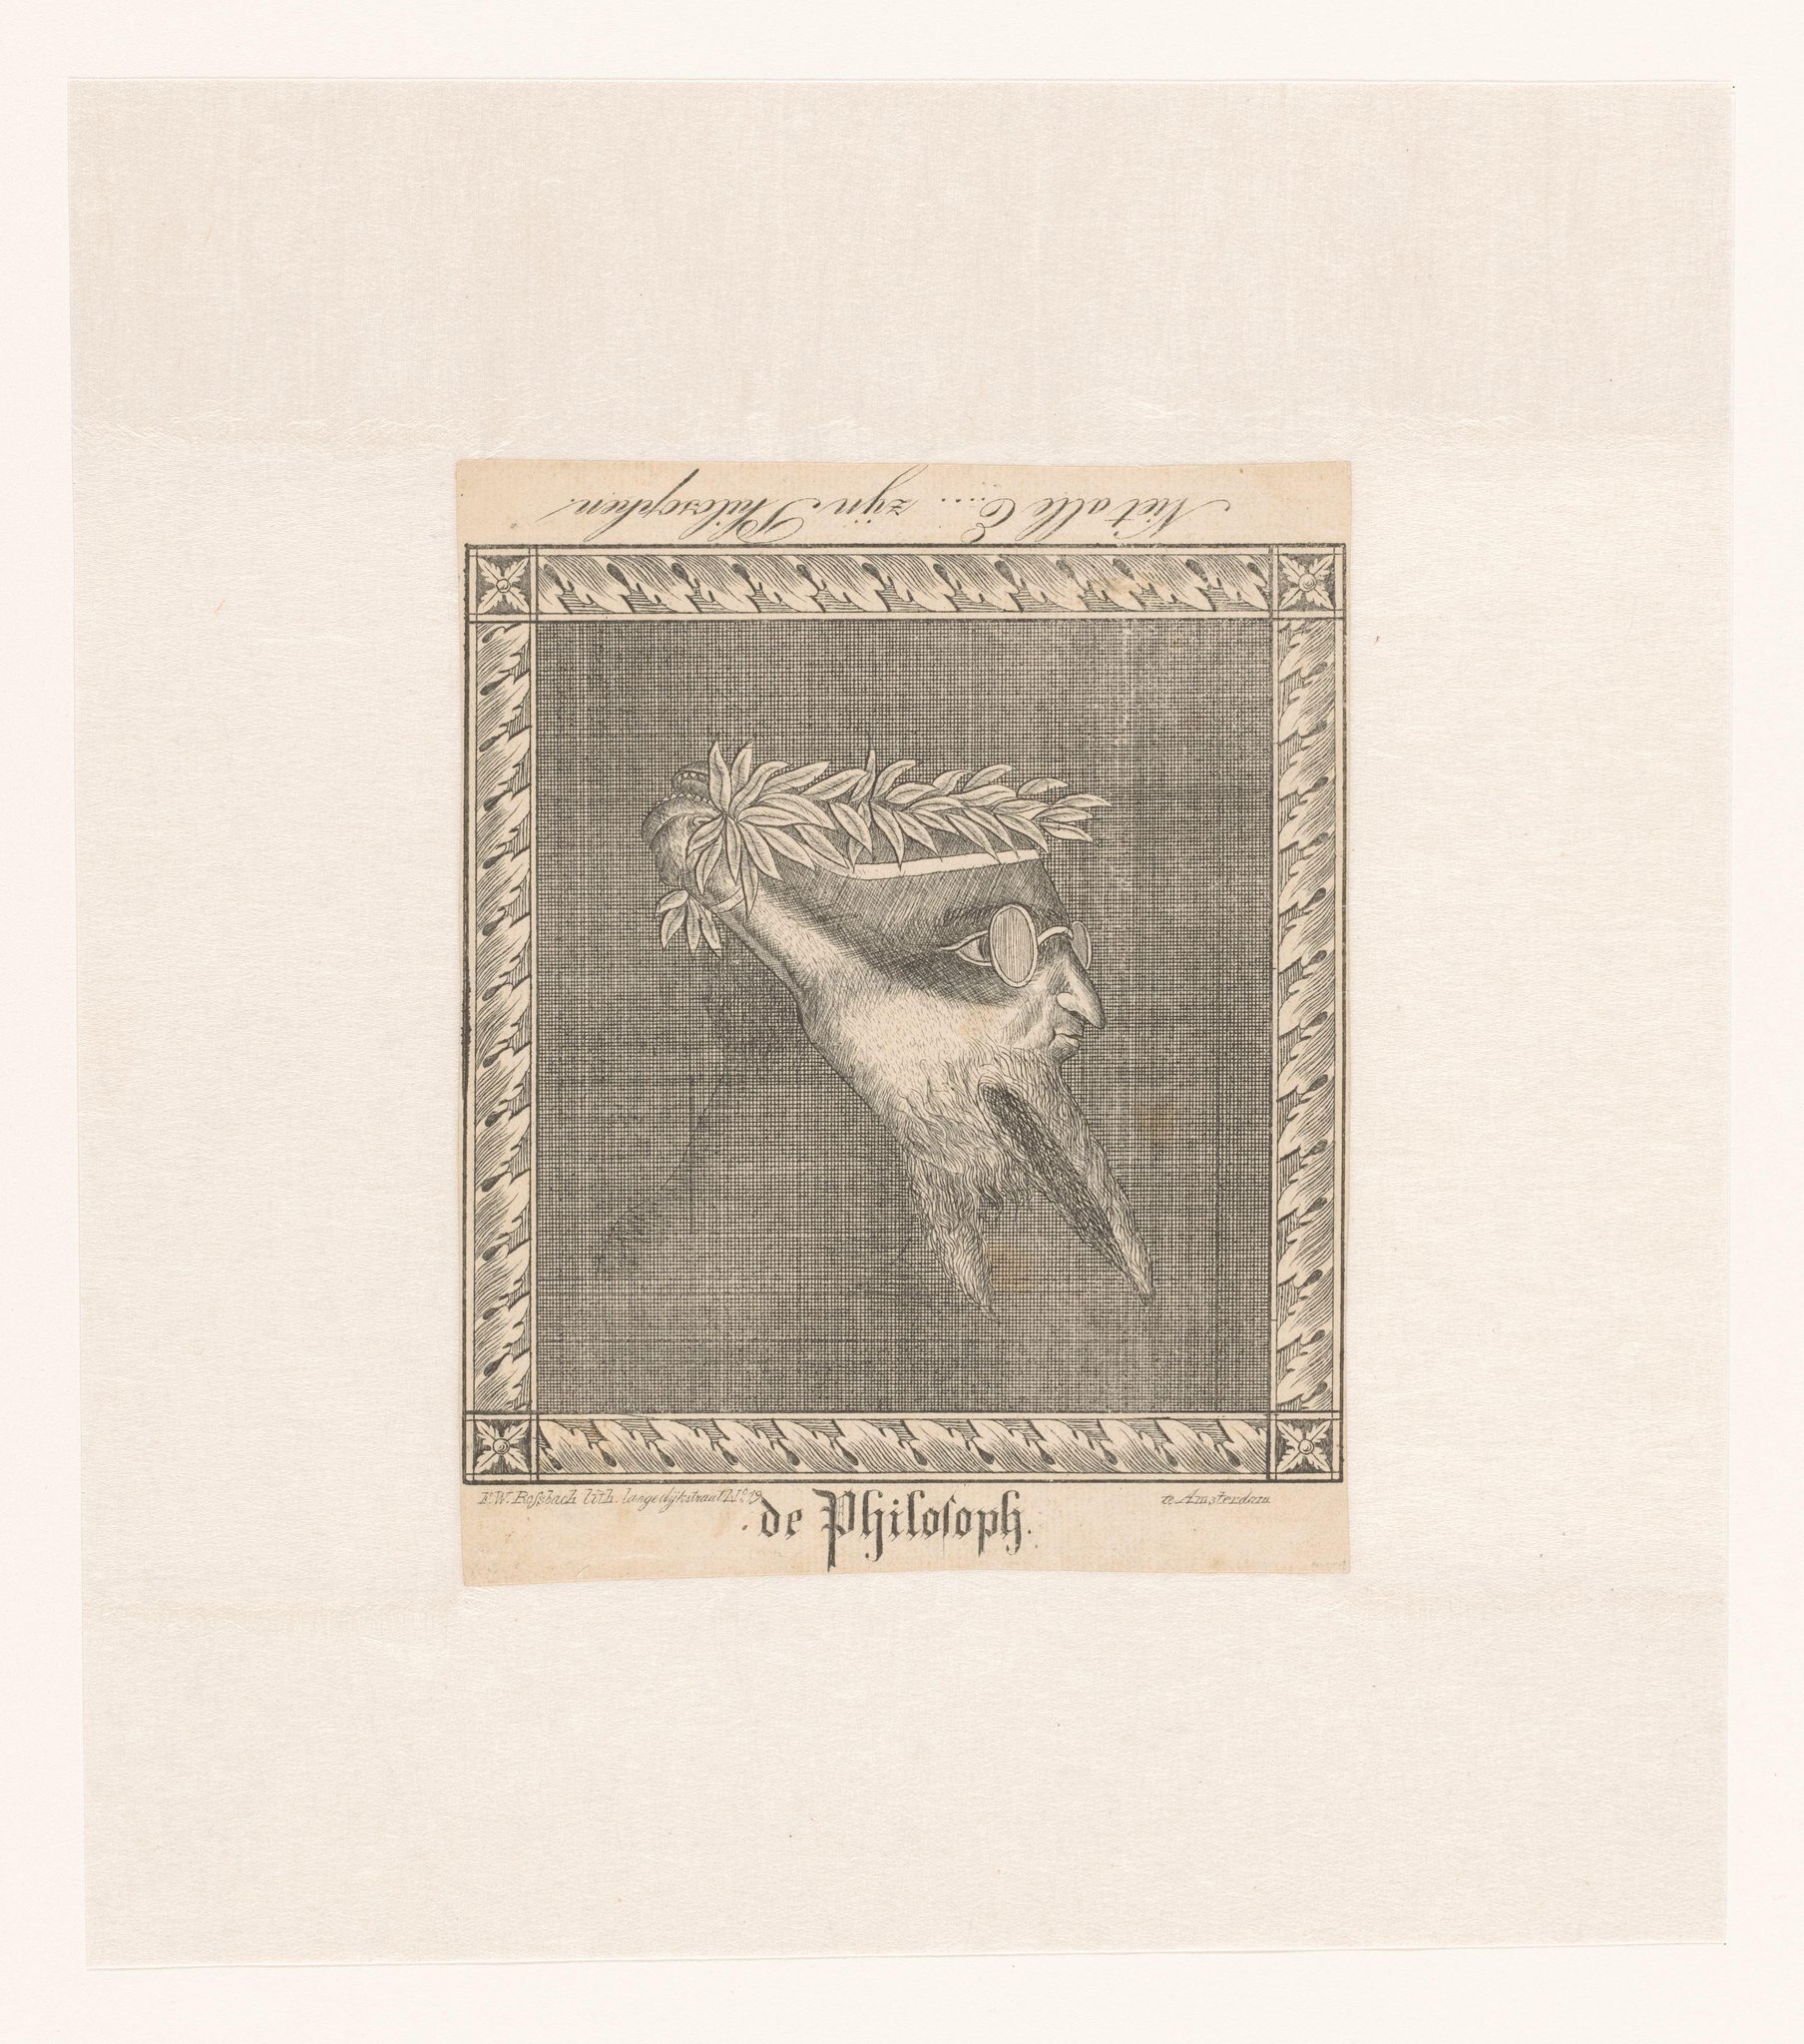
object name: print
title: Omkeerprent met het gelauwerde hoofd van een filosoof en een ezelskop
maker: friedrich wilhelm rossbach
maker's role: print maker, printer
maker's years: 1806-1861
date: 1838-1841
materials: paper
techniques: lithograph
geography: amsterdam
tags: ass, donkey, scholar, philosopher, crowning with laurel, political caricatures and satires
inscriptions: collector's mark: Lugt 2760, collector's mark: Lugt 2228